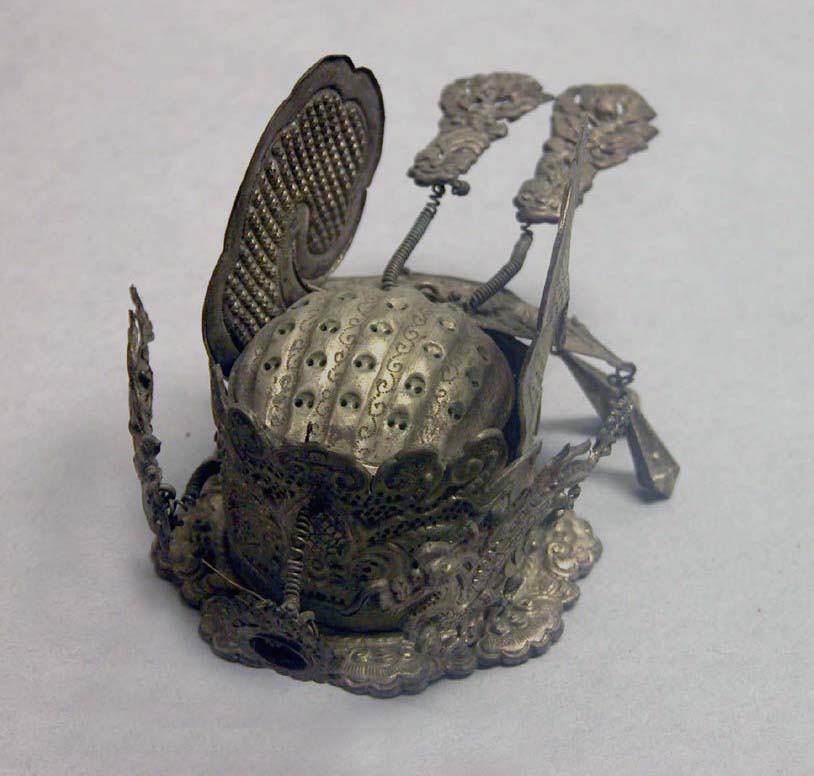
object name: headdress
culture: chinese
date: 960-1279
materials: silver